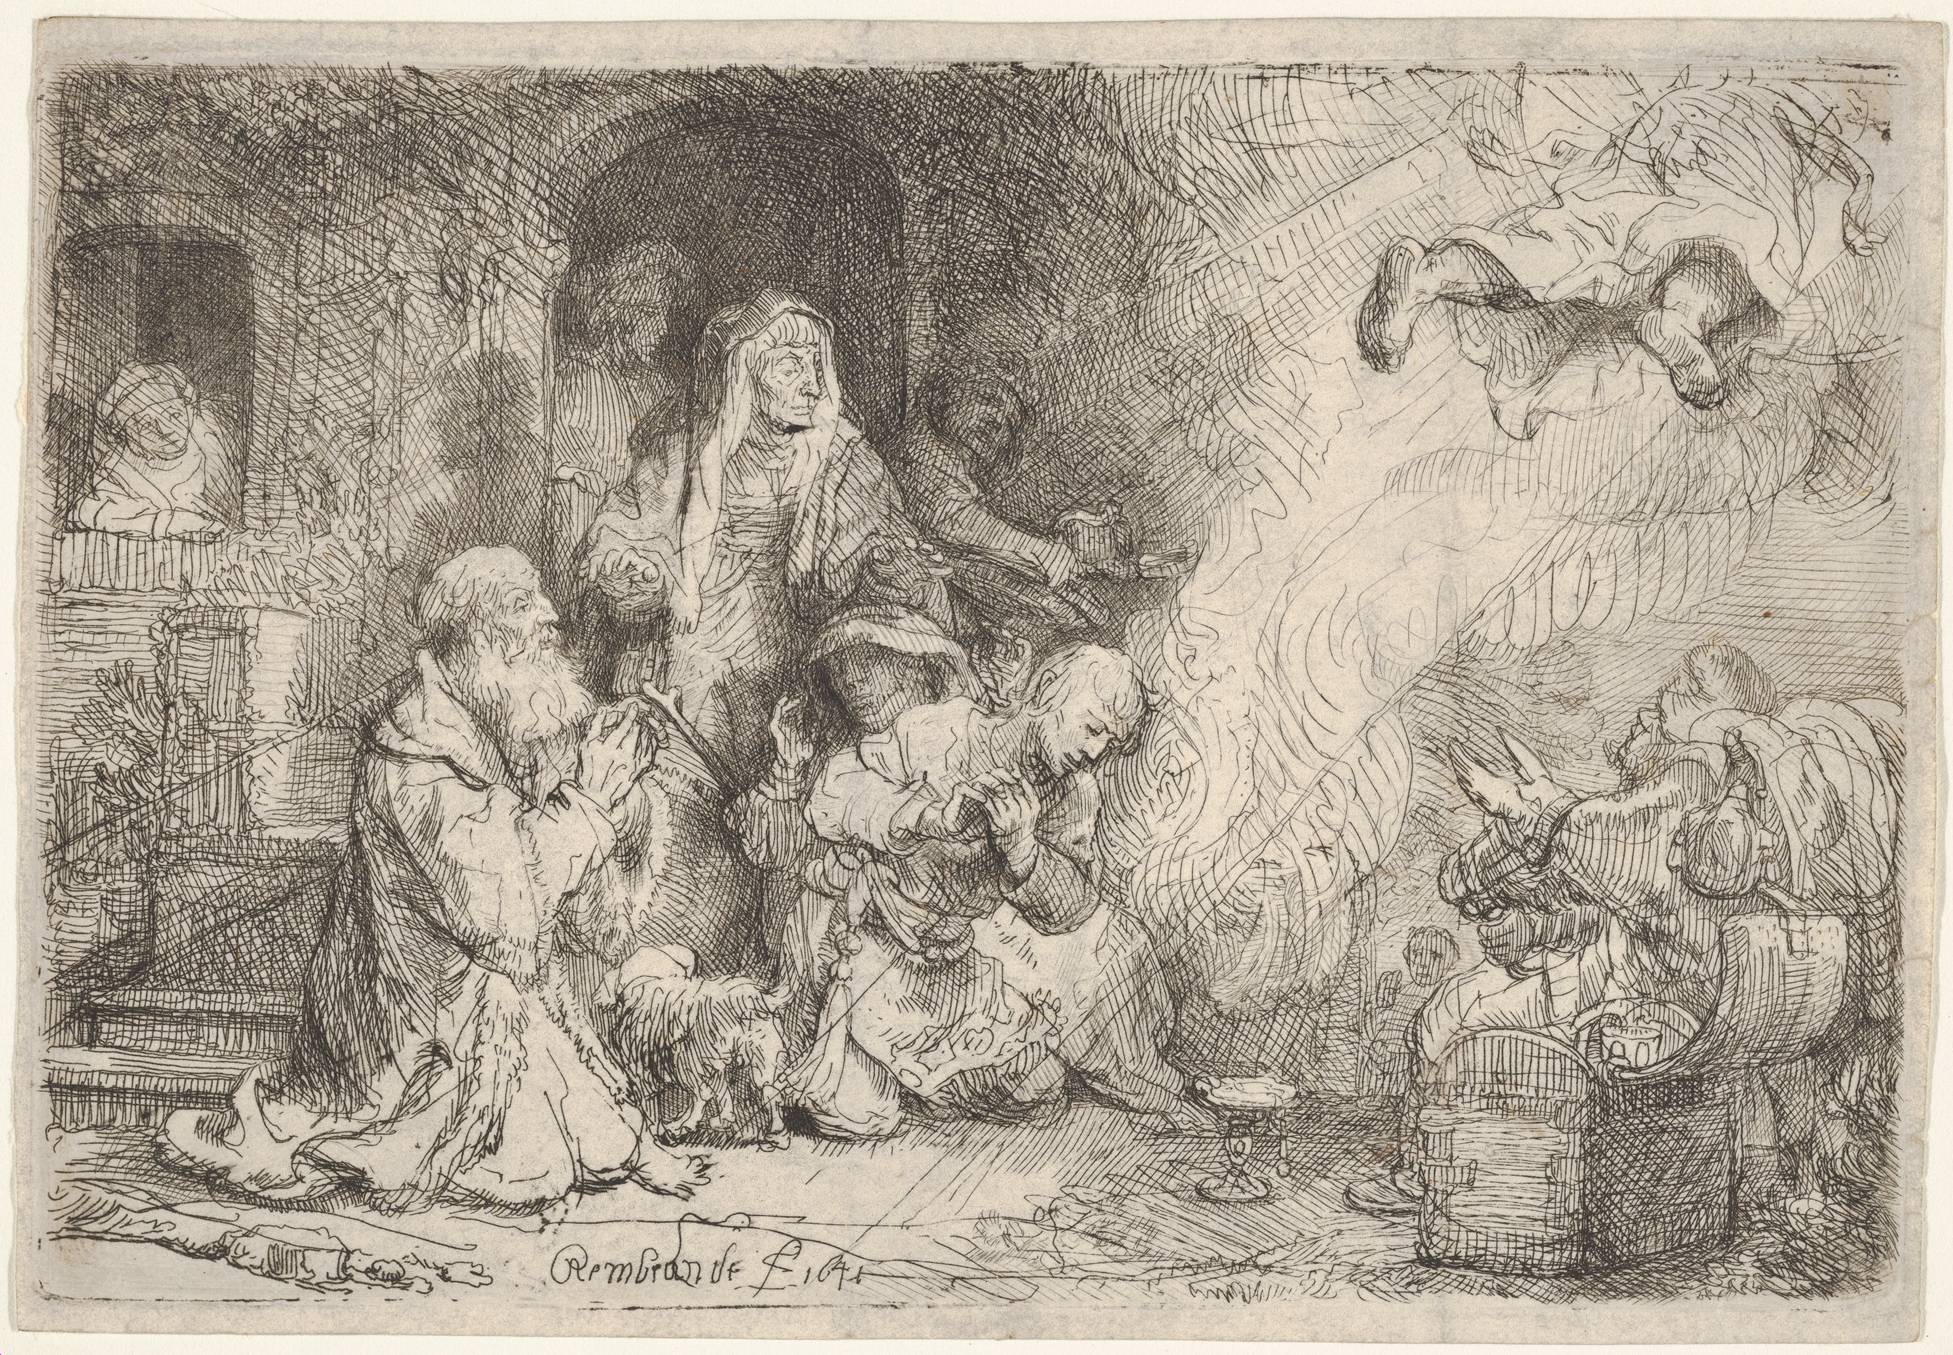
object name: print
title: The Angel Leaving the Family of Tobias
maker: rembrandt van rijn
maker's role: artist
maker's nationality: dutch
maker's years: 1606-1669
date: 1641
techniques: etching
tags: men,women,angels